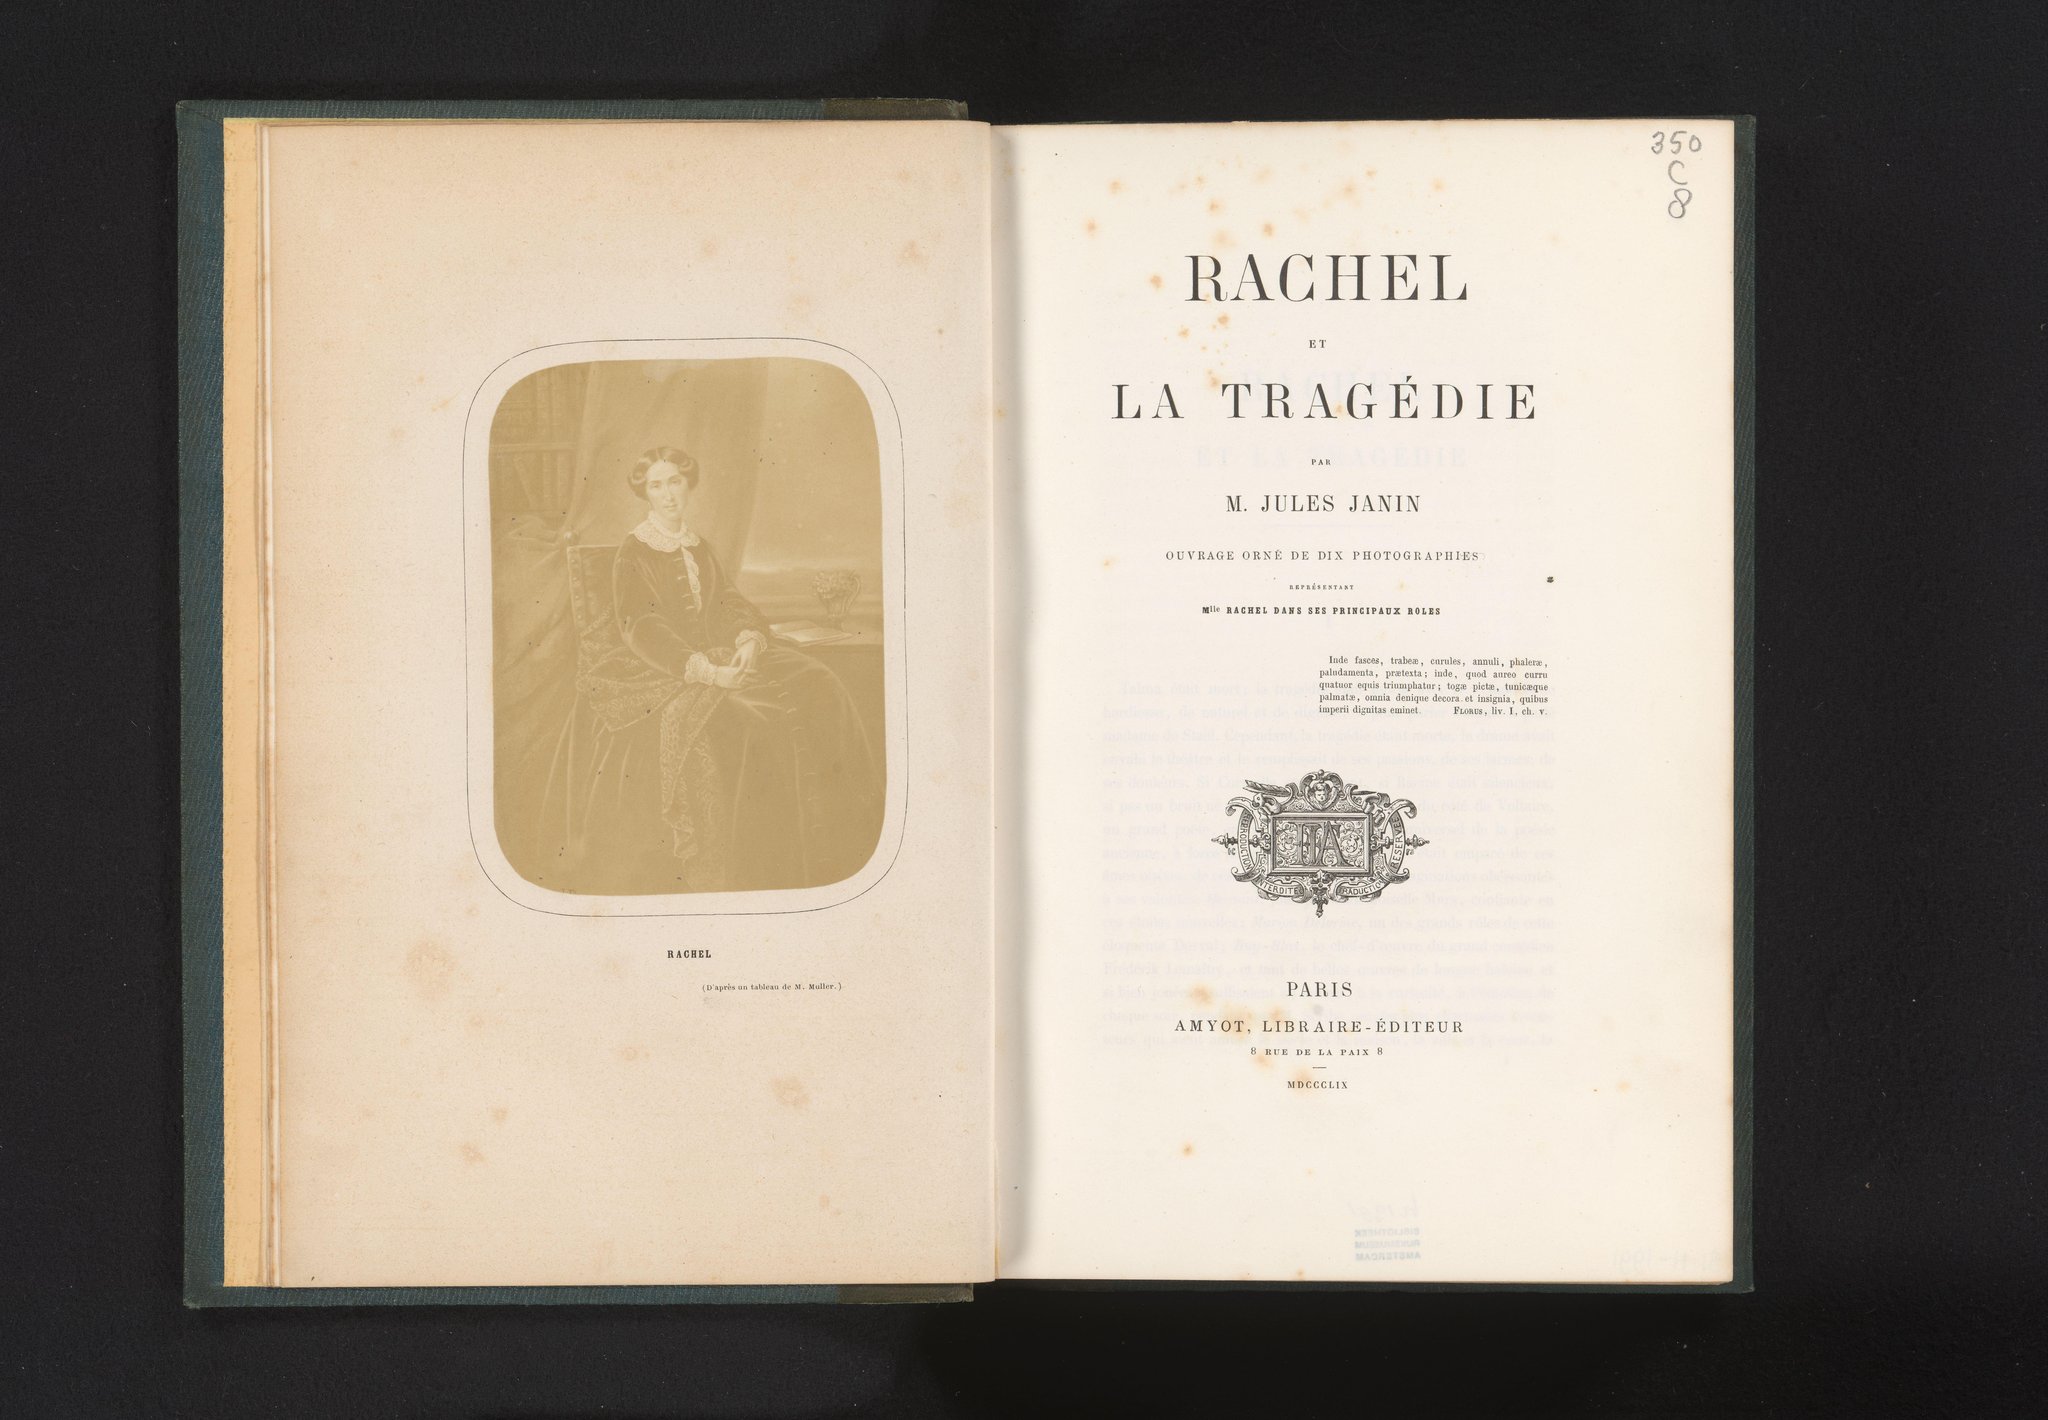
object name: photograph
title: Fotoreproductie van een schilderij met een portret van Elizabeth-Rache Félix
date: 1851-1859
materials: paper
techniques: albumen print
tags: adult woman, picture, painting